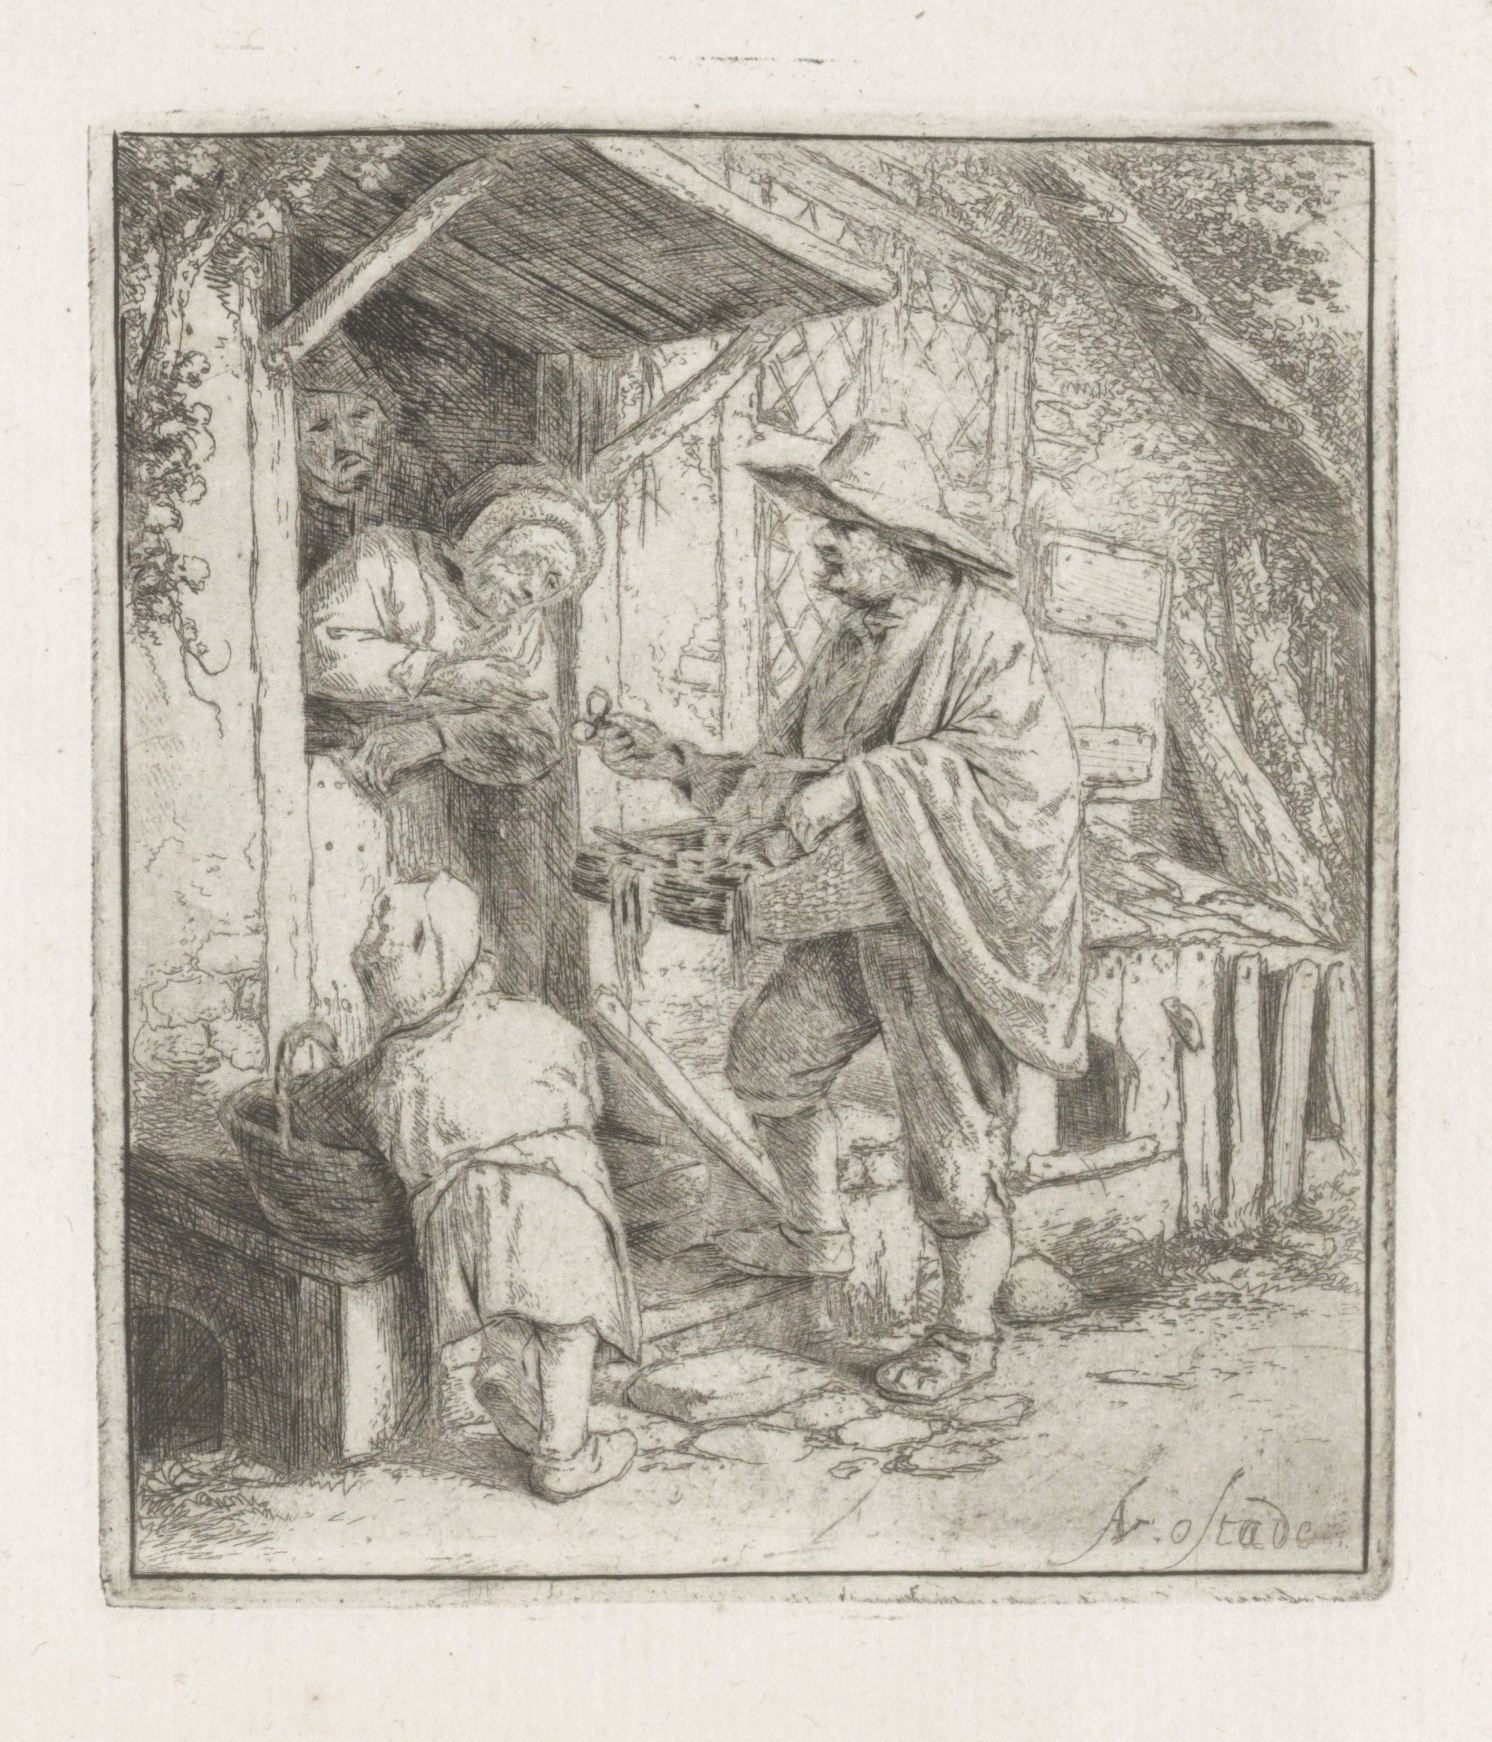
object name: album leaf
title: Brillenverkoper bij een oude vrouw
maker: adriaen van ostade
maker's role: draughtsman, painter, print maker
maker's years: 1610-1685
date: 1647-1652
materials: paper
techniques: etching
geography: haarlem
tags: eyeglasses, spectacles, old woman, wandering or travelling merchant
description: Een brillenverkoper met een mand vol brillen staat voor het huis van een oude vrouw. Zij leunt op de onderdeur. Een kind met een mand kijkt toe. Deze prent maakt deel uit van een album.